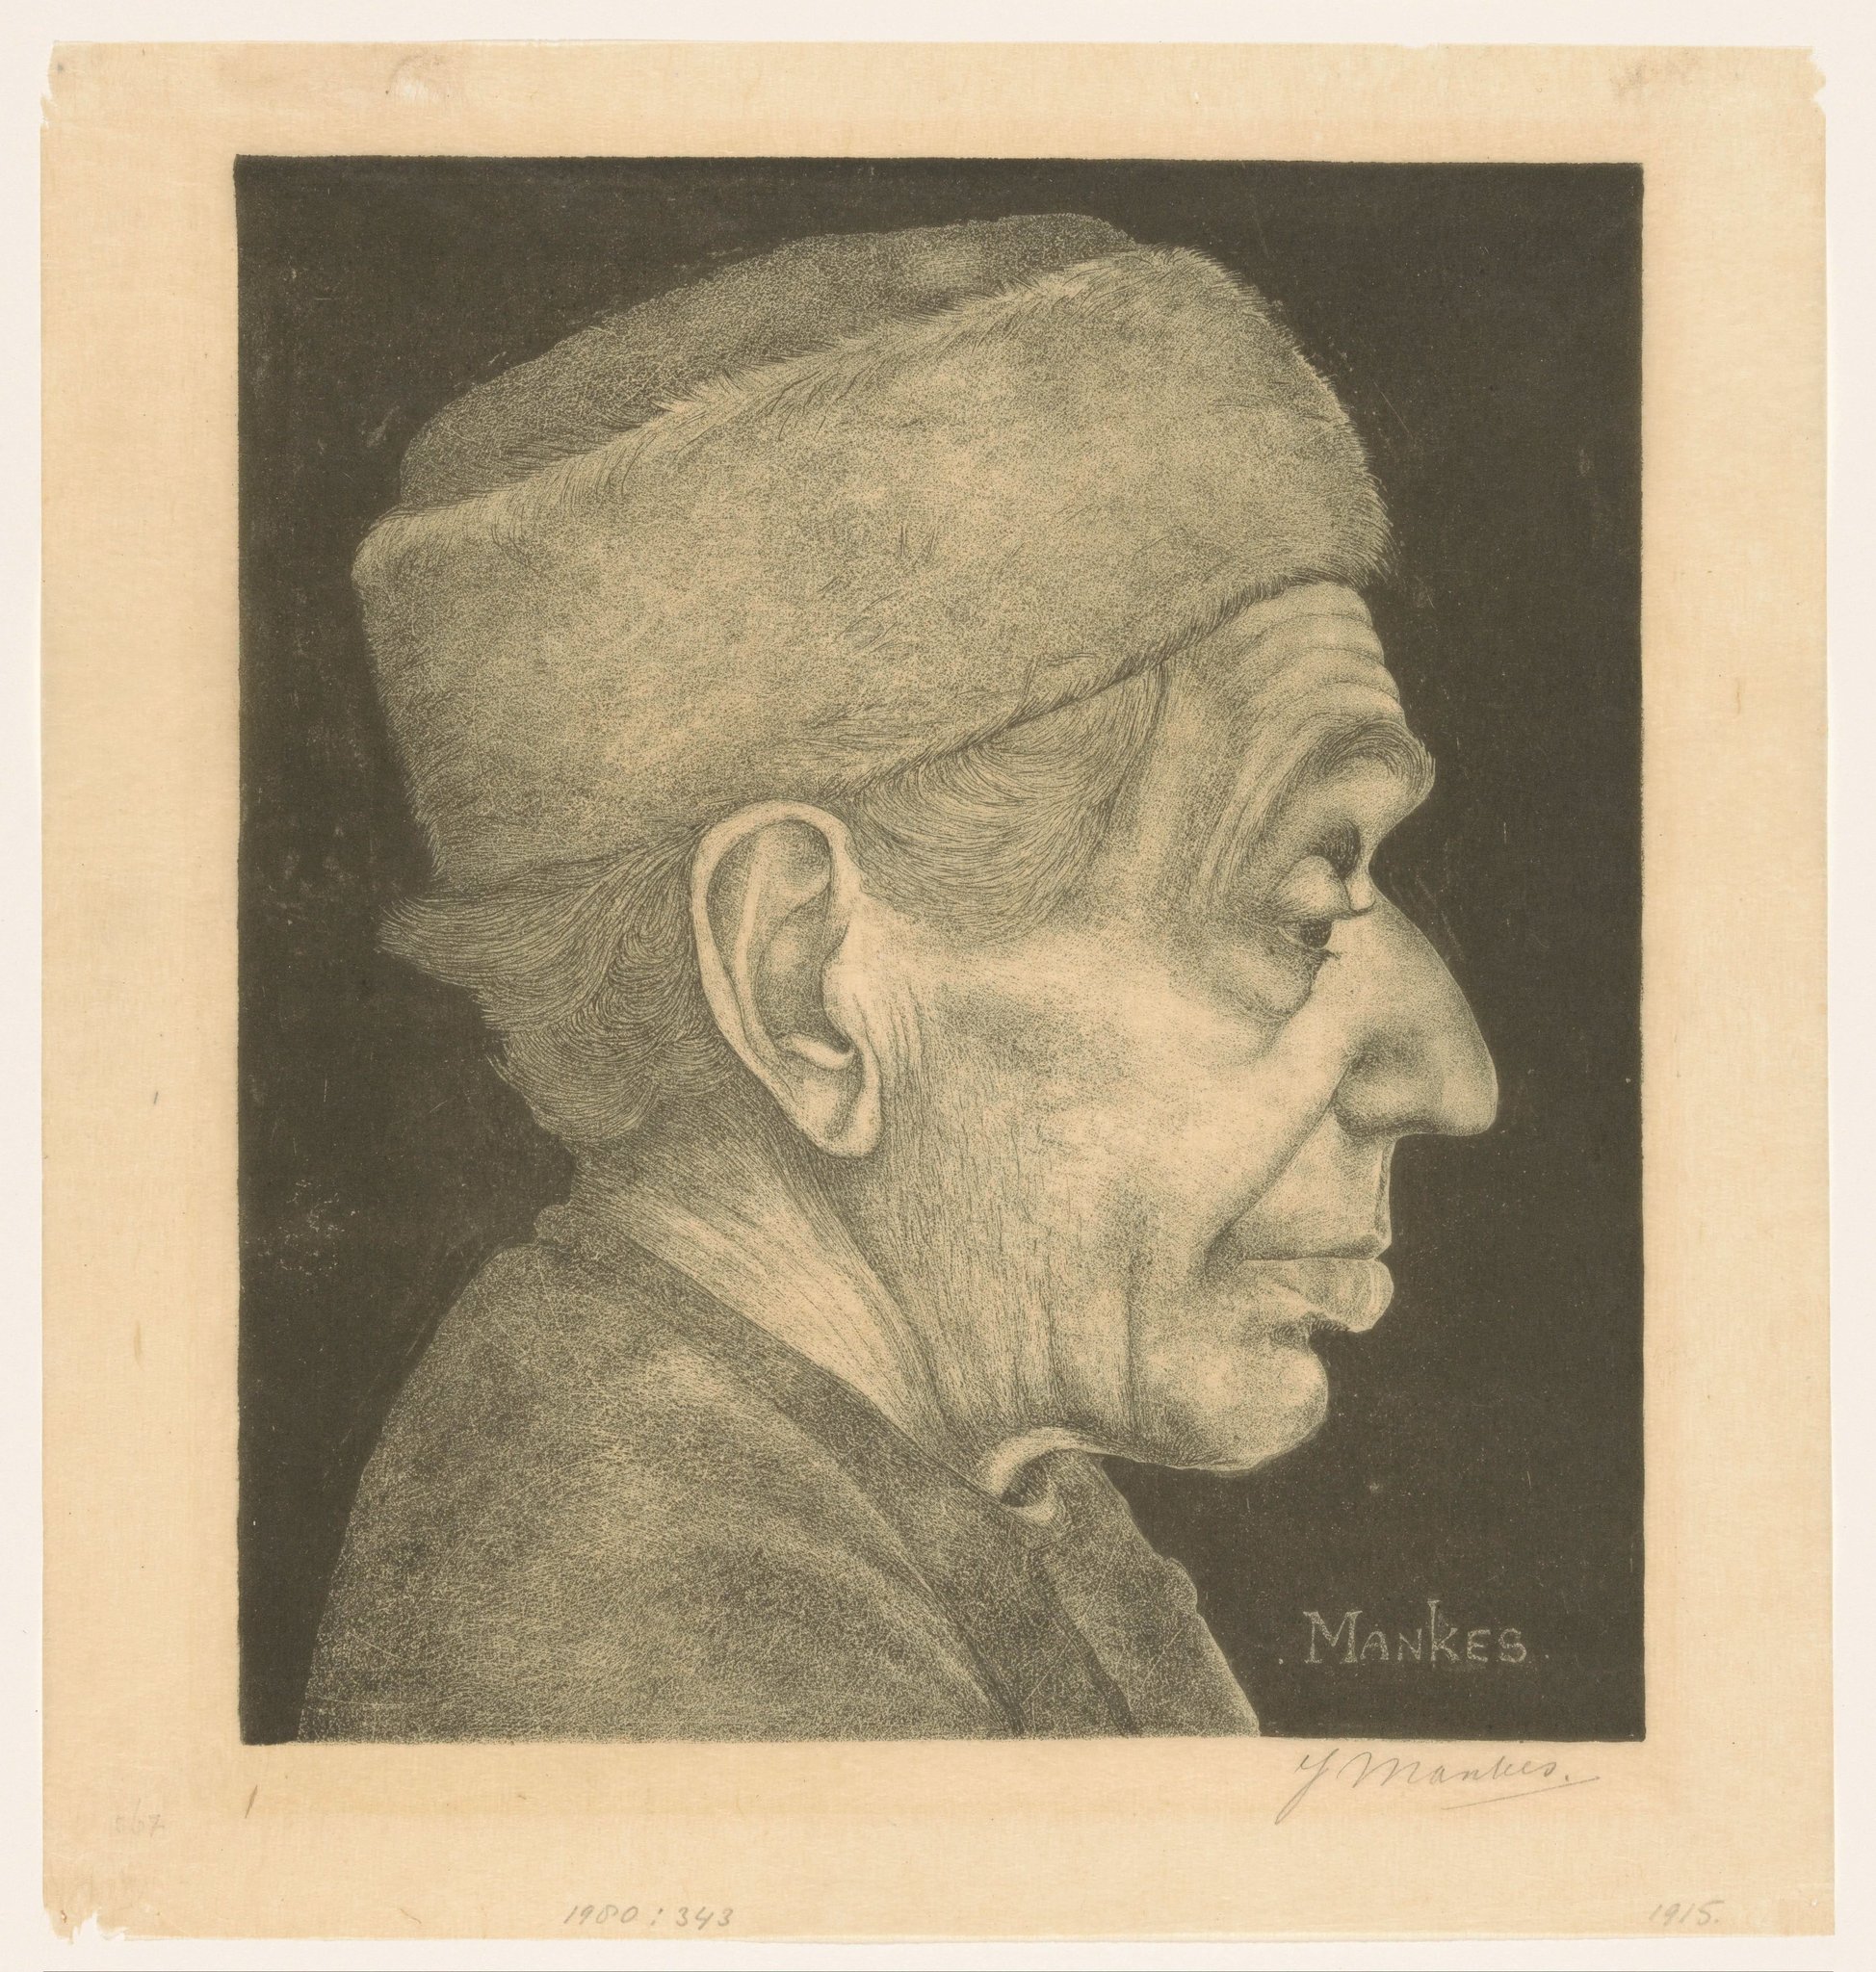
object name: print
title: Portret van Douwe met muts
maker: jan mankes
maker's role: draughtsman, painter, print maker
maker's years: 1889-1920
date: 1914-1915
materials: paper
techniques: lithograph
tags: head-gear: hat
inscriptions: collector's mark: Lugt 2228